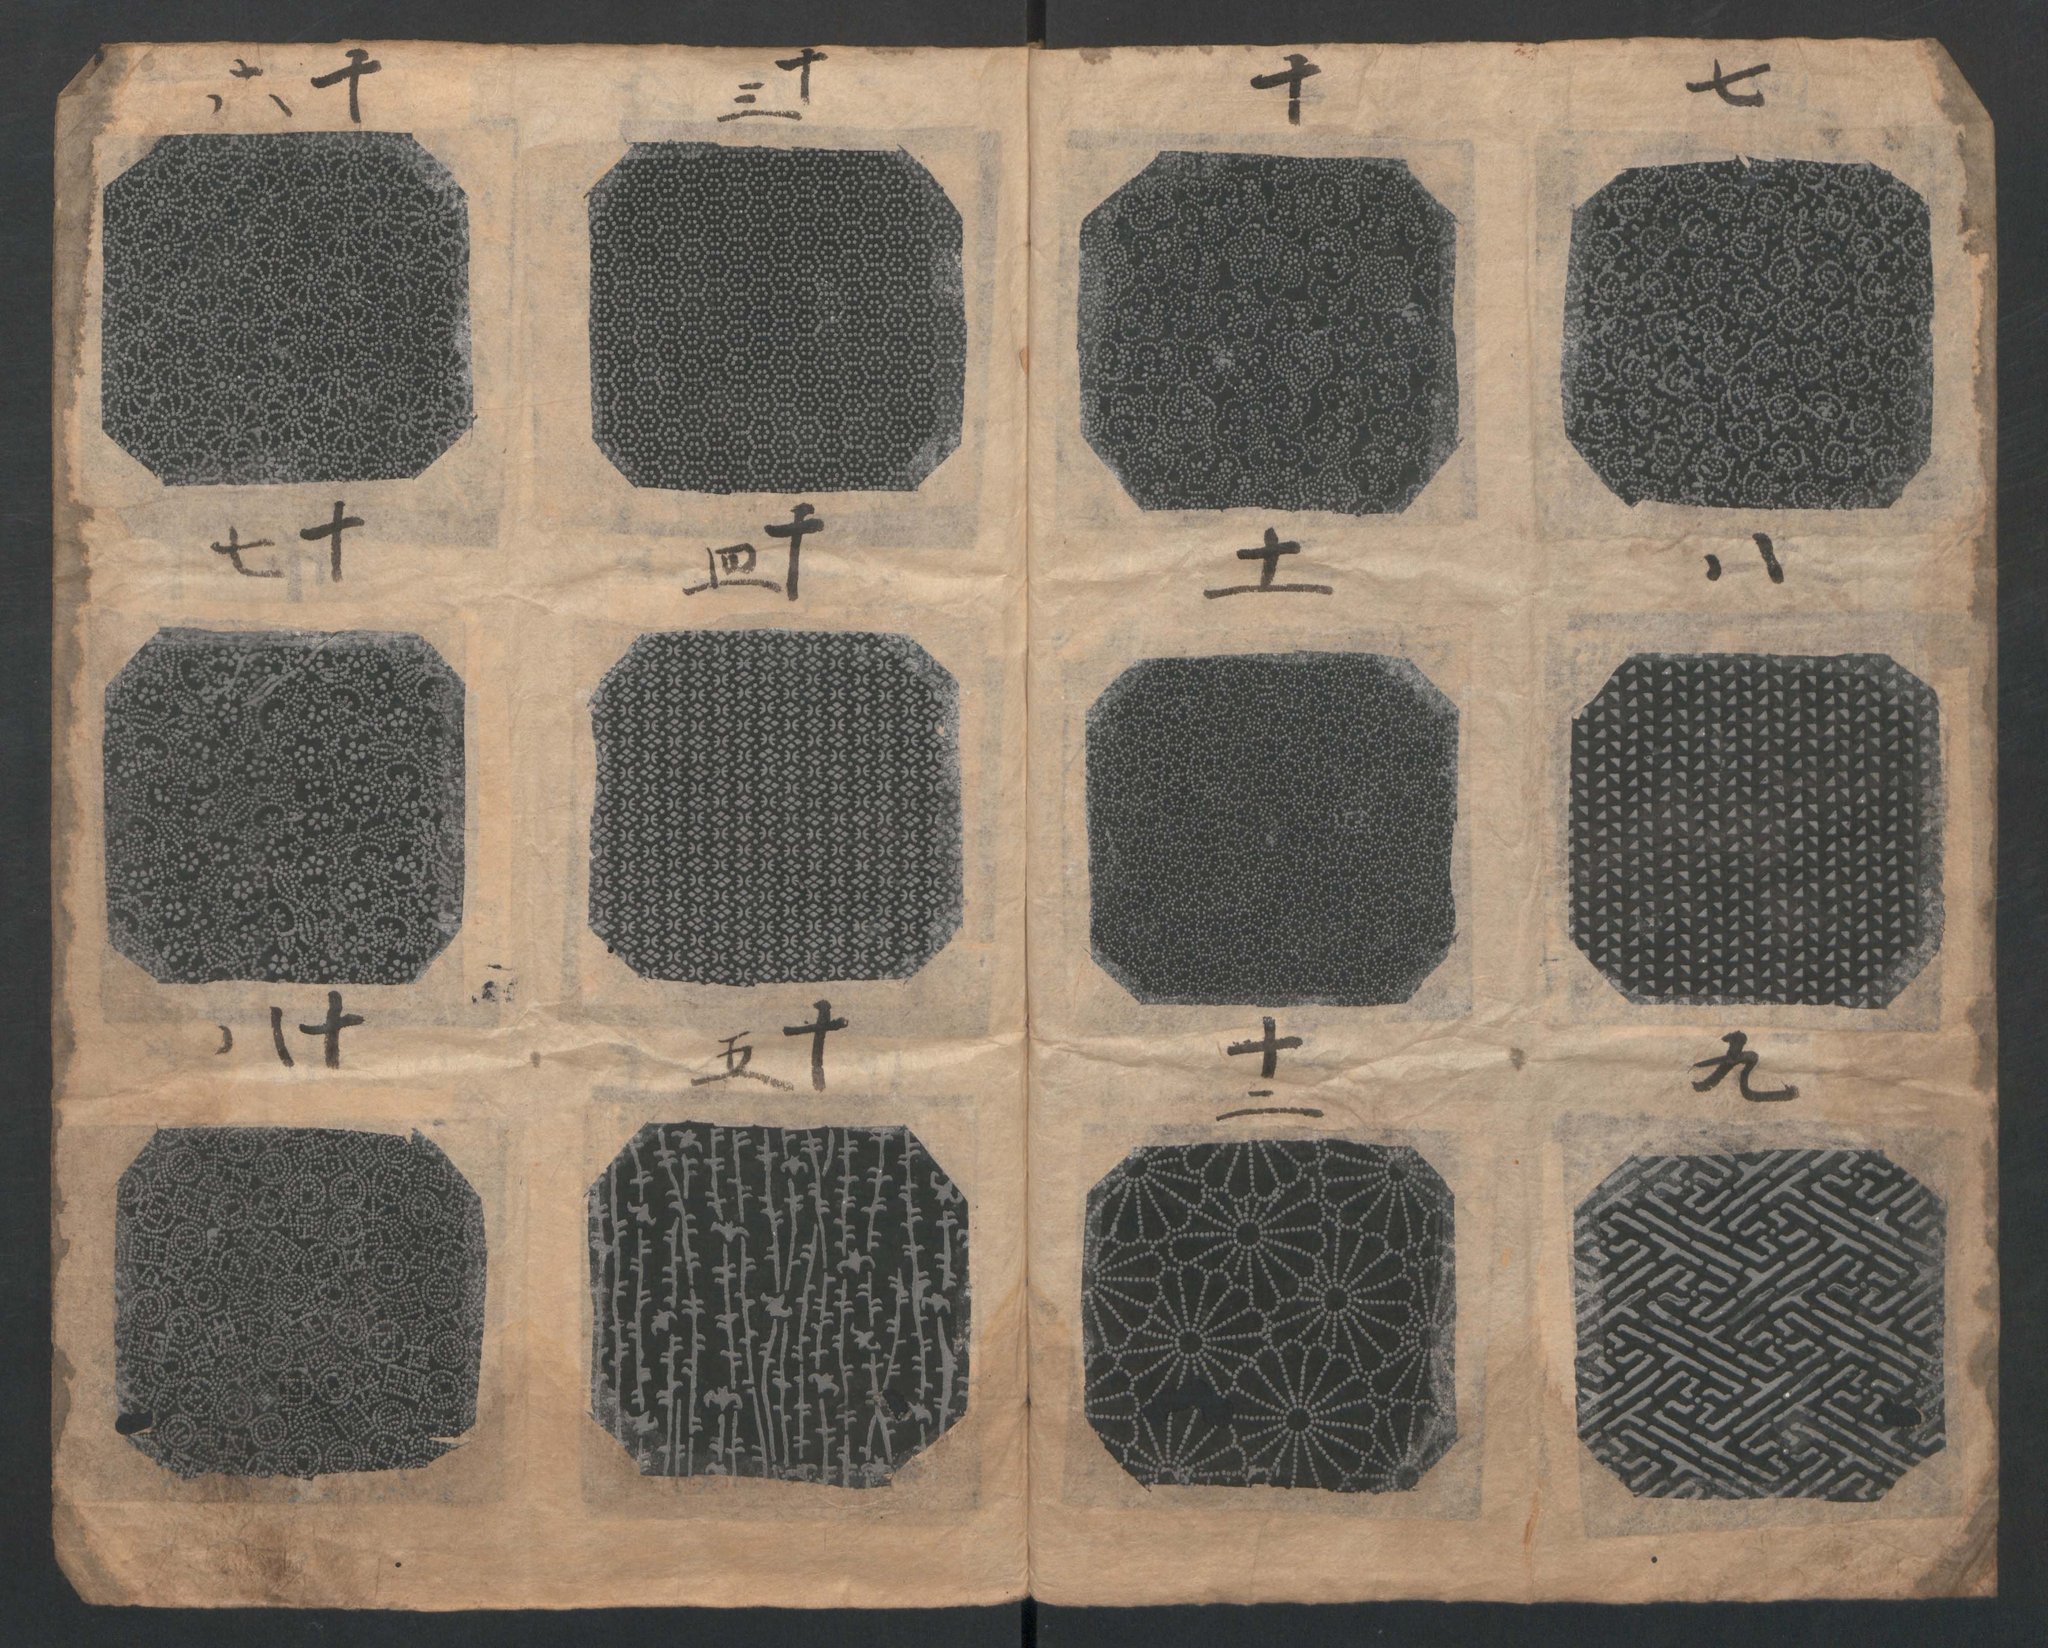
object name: illustrated book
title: Book of Designs (Katazome mihonchō) 型染見本帖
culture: japanese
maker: unidentified artist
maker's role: artist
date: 1680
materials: ink, paper